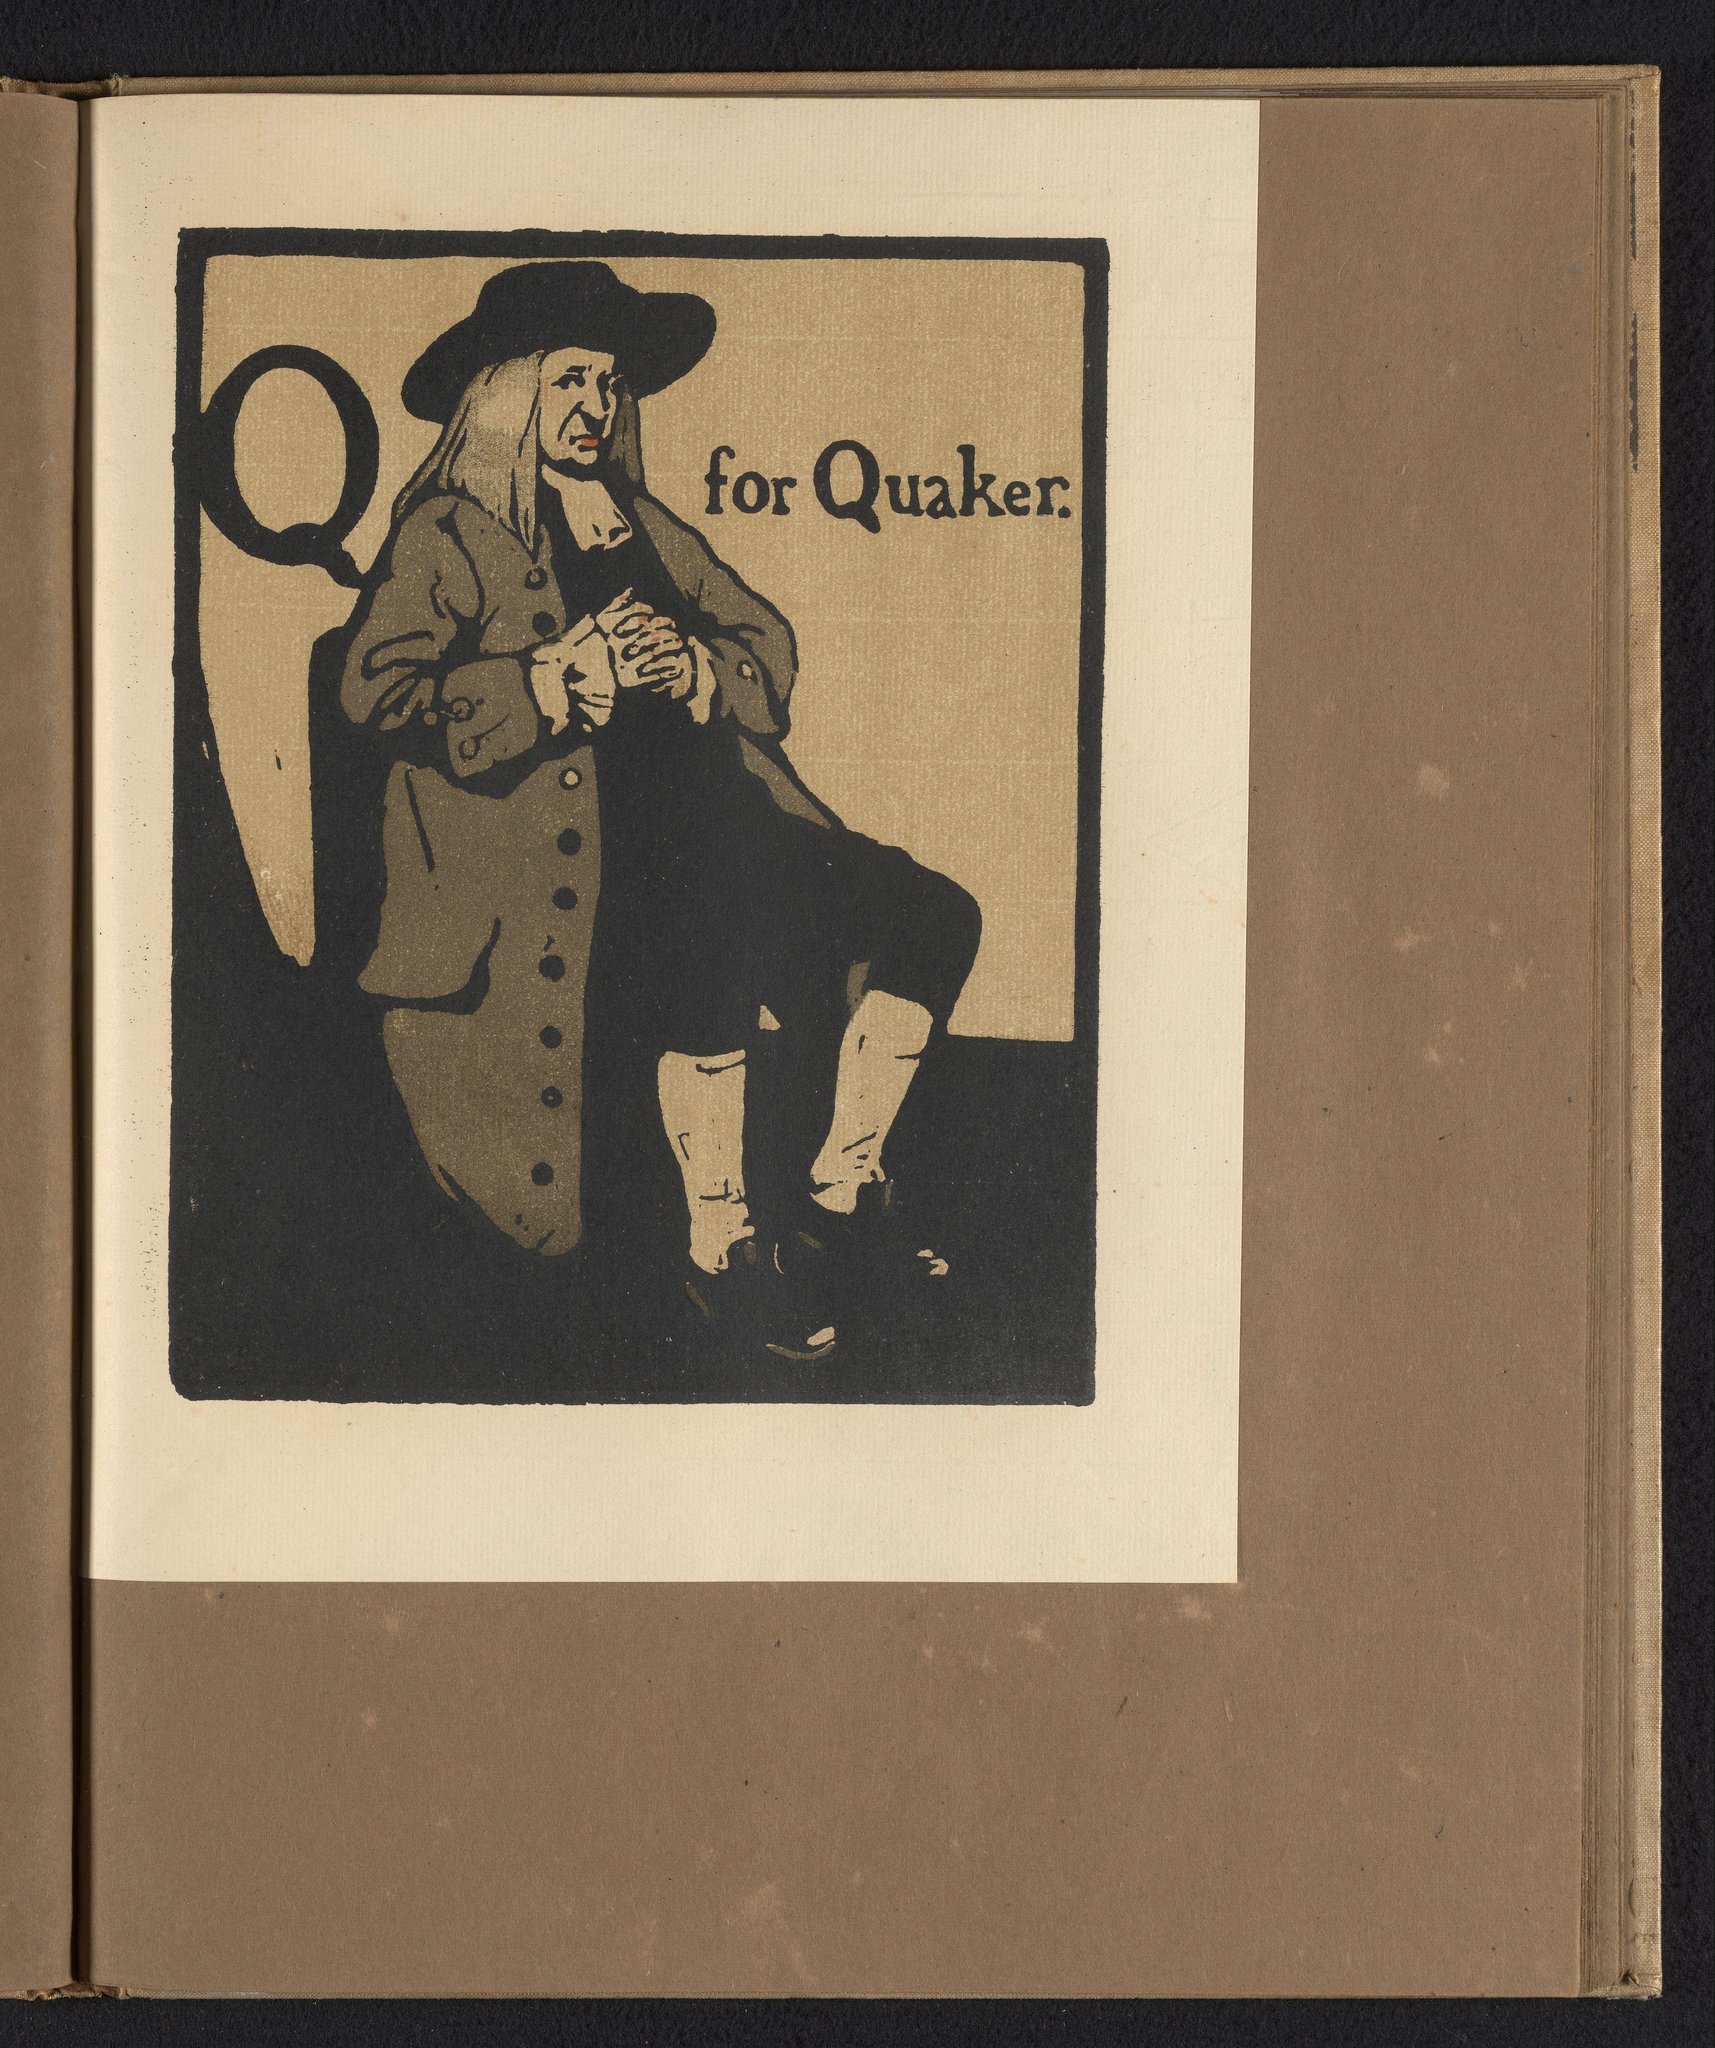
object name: page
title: An Alphabet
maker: william heinemann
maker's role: publisher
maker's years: 1863-1920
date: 1898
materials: paper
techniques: lithograph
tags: protestant churches and denominations (with name), adult man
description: De serie met lithografieën is gemaakt naar ontwerpen van houtsneden door William Nicholson.